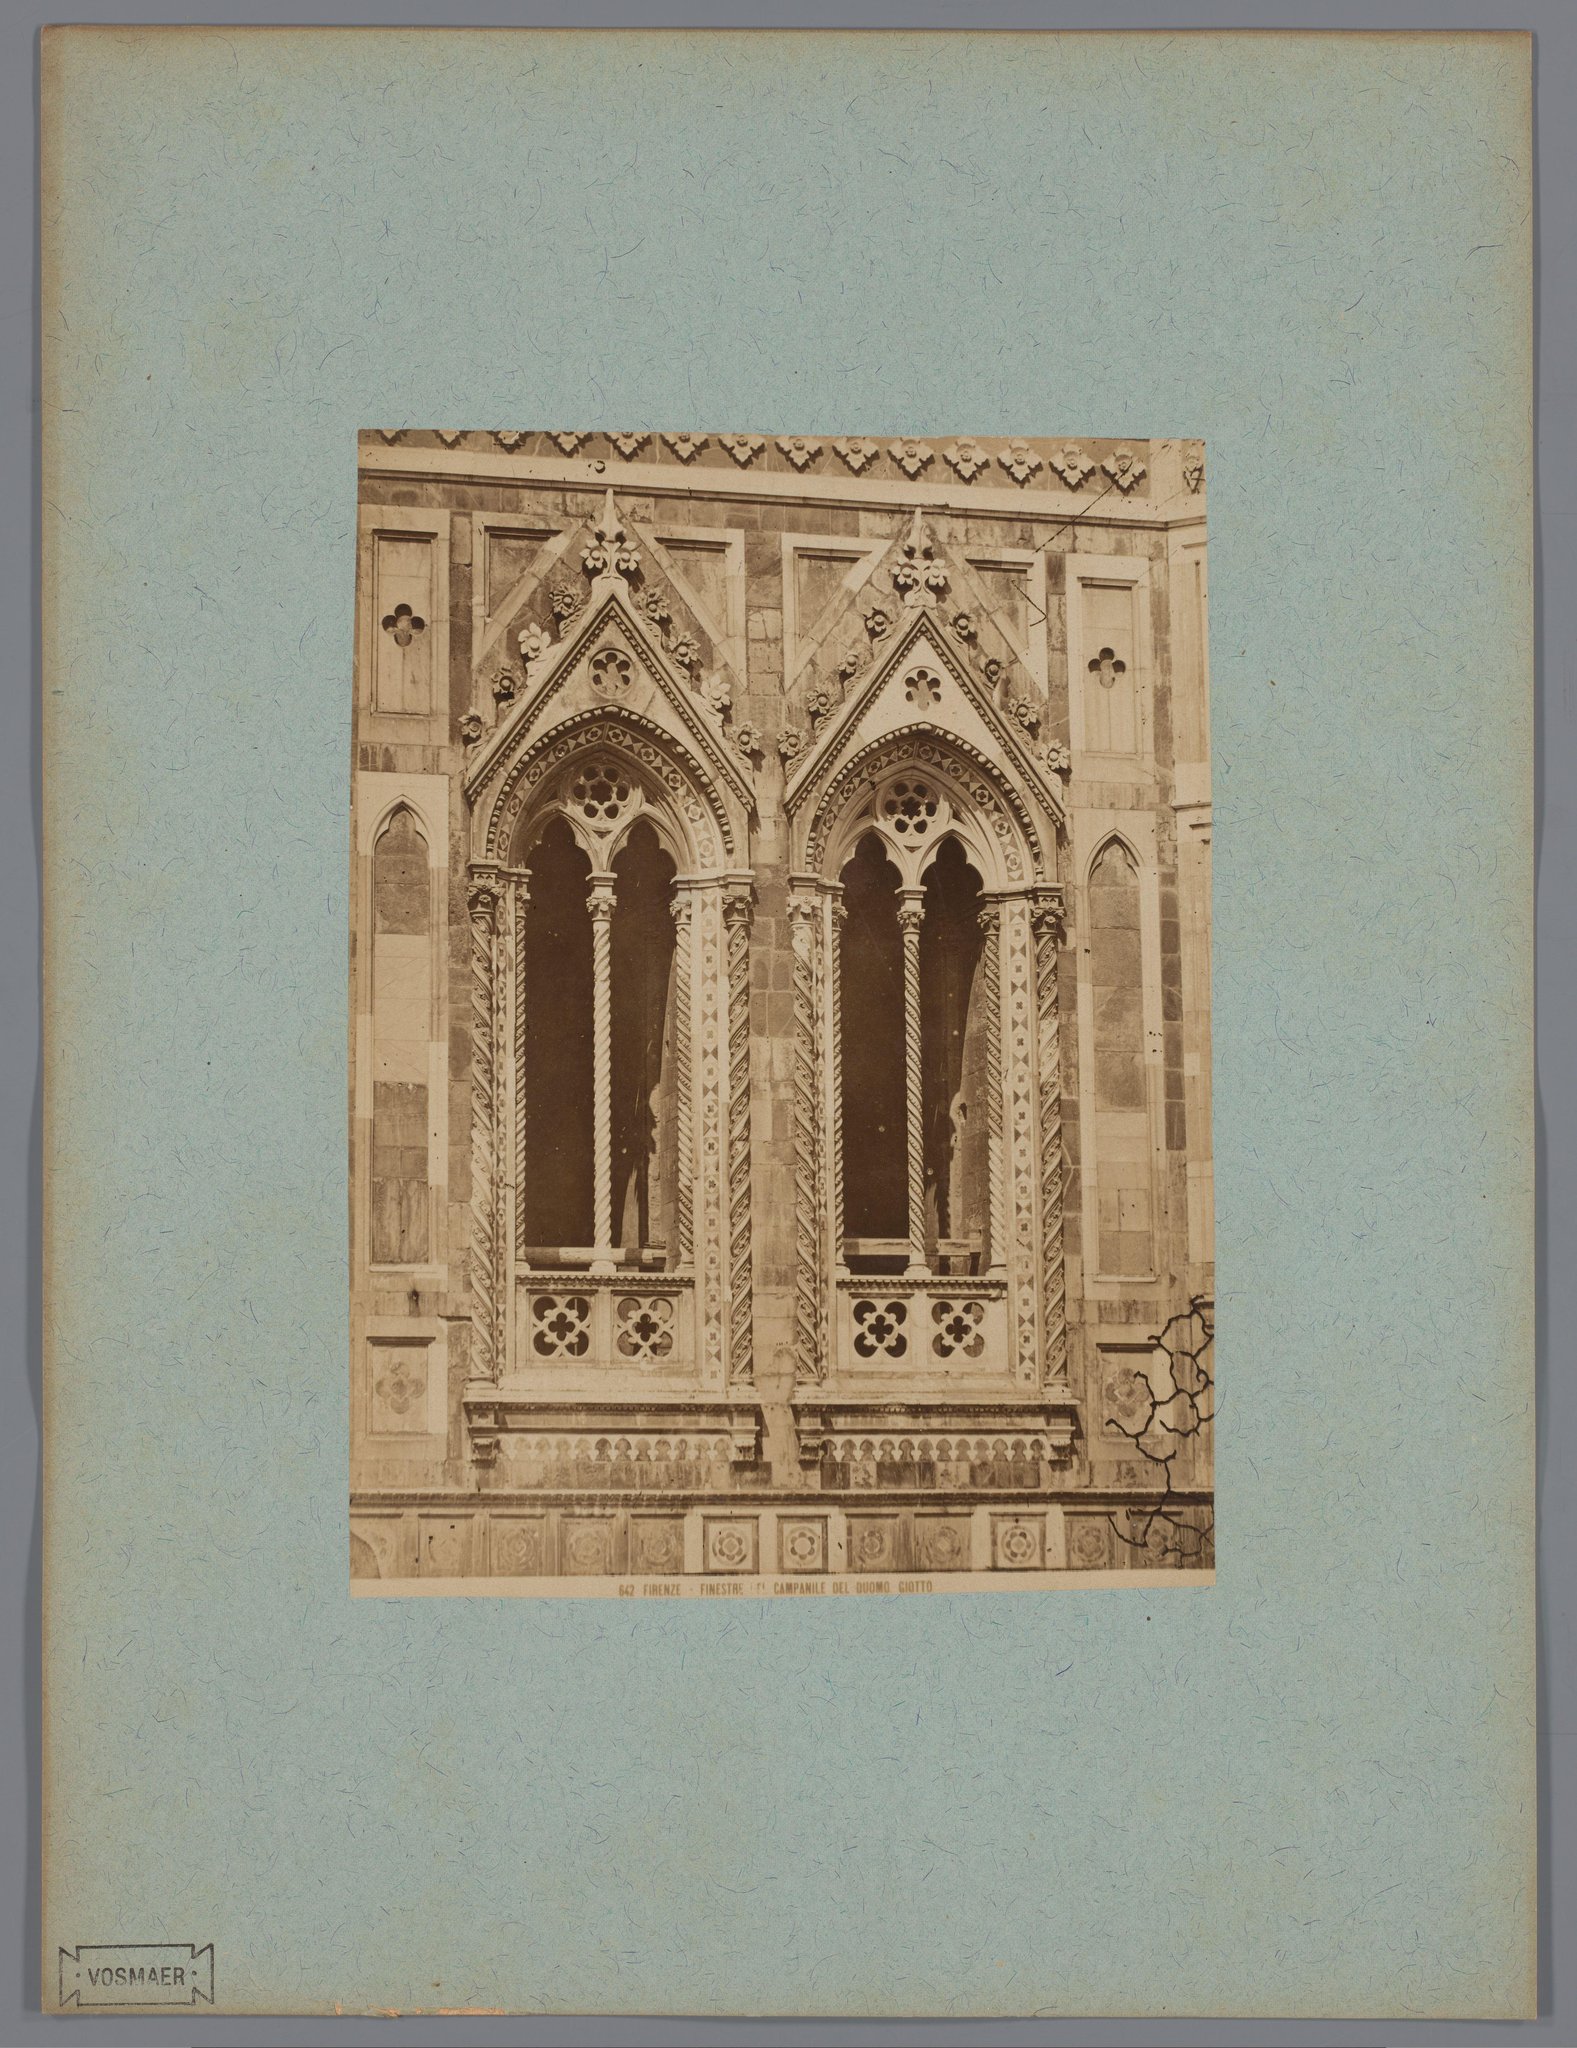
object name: photograph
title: Firenze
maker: Anonymous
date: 1851-1900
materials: cardboard, paper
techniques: albumen print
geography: florence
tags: university building, college, zoology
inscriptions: number: ‘642’, collector's mark: ‘VOSMAER’